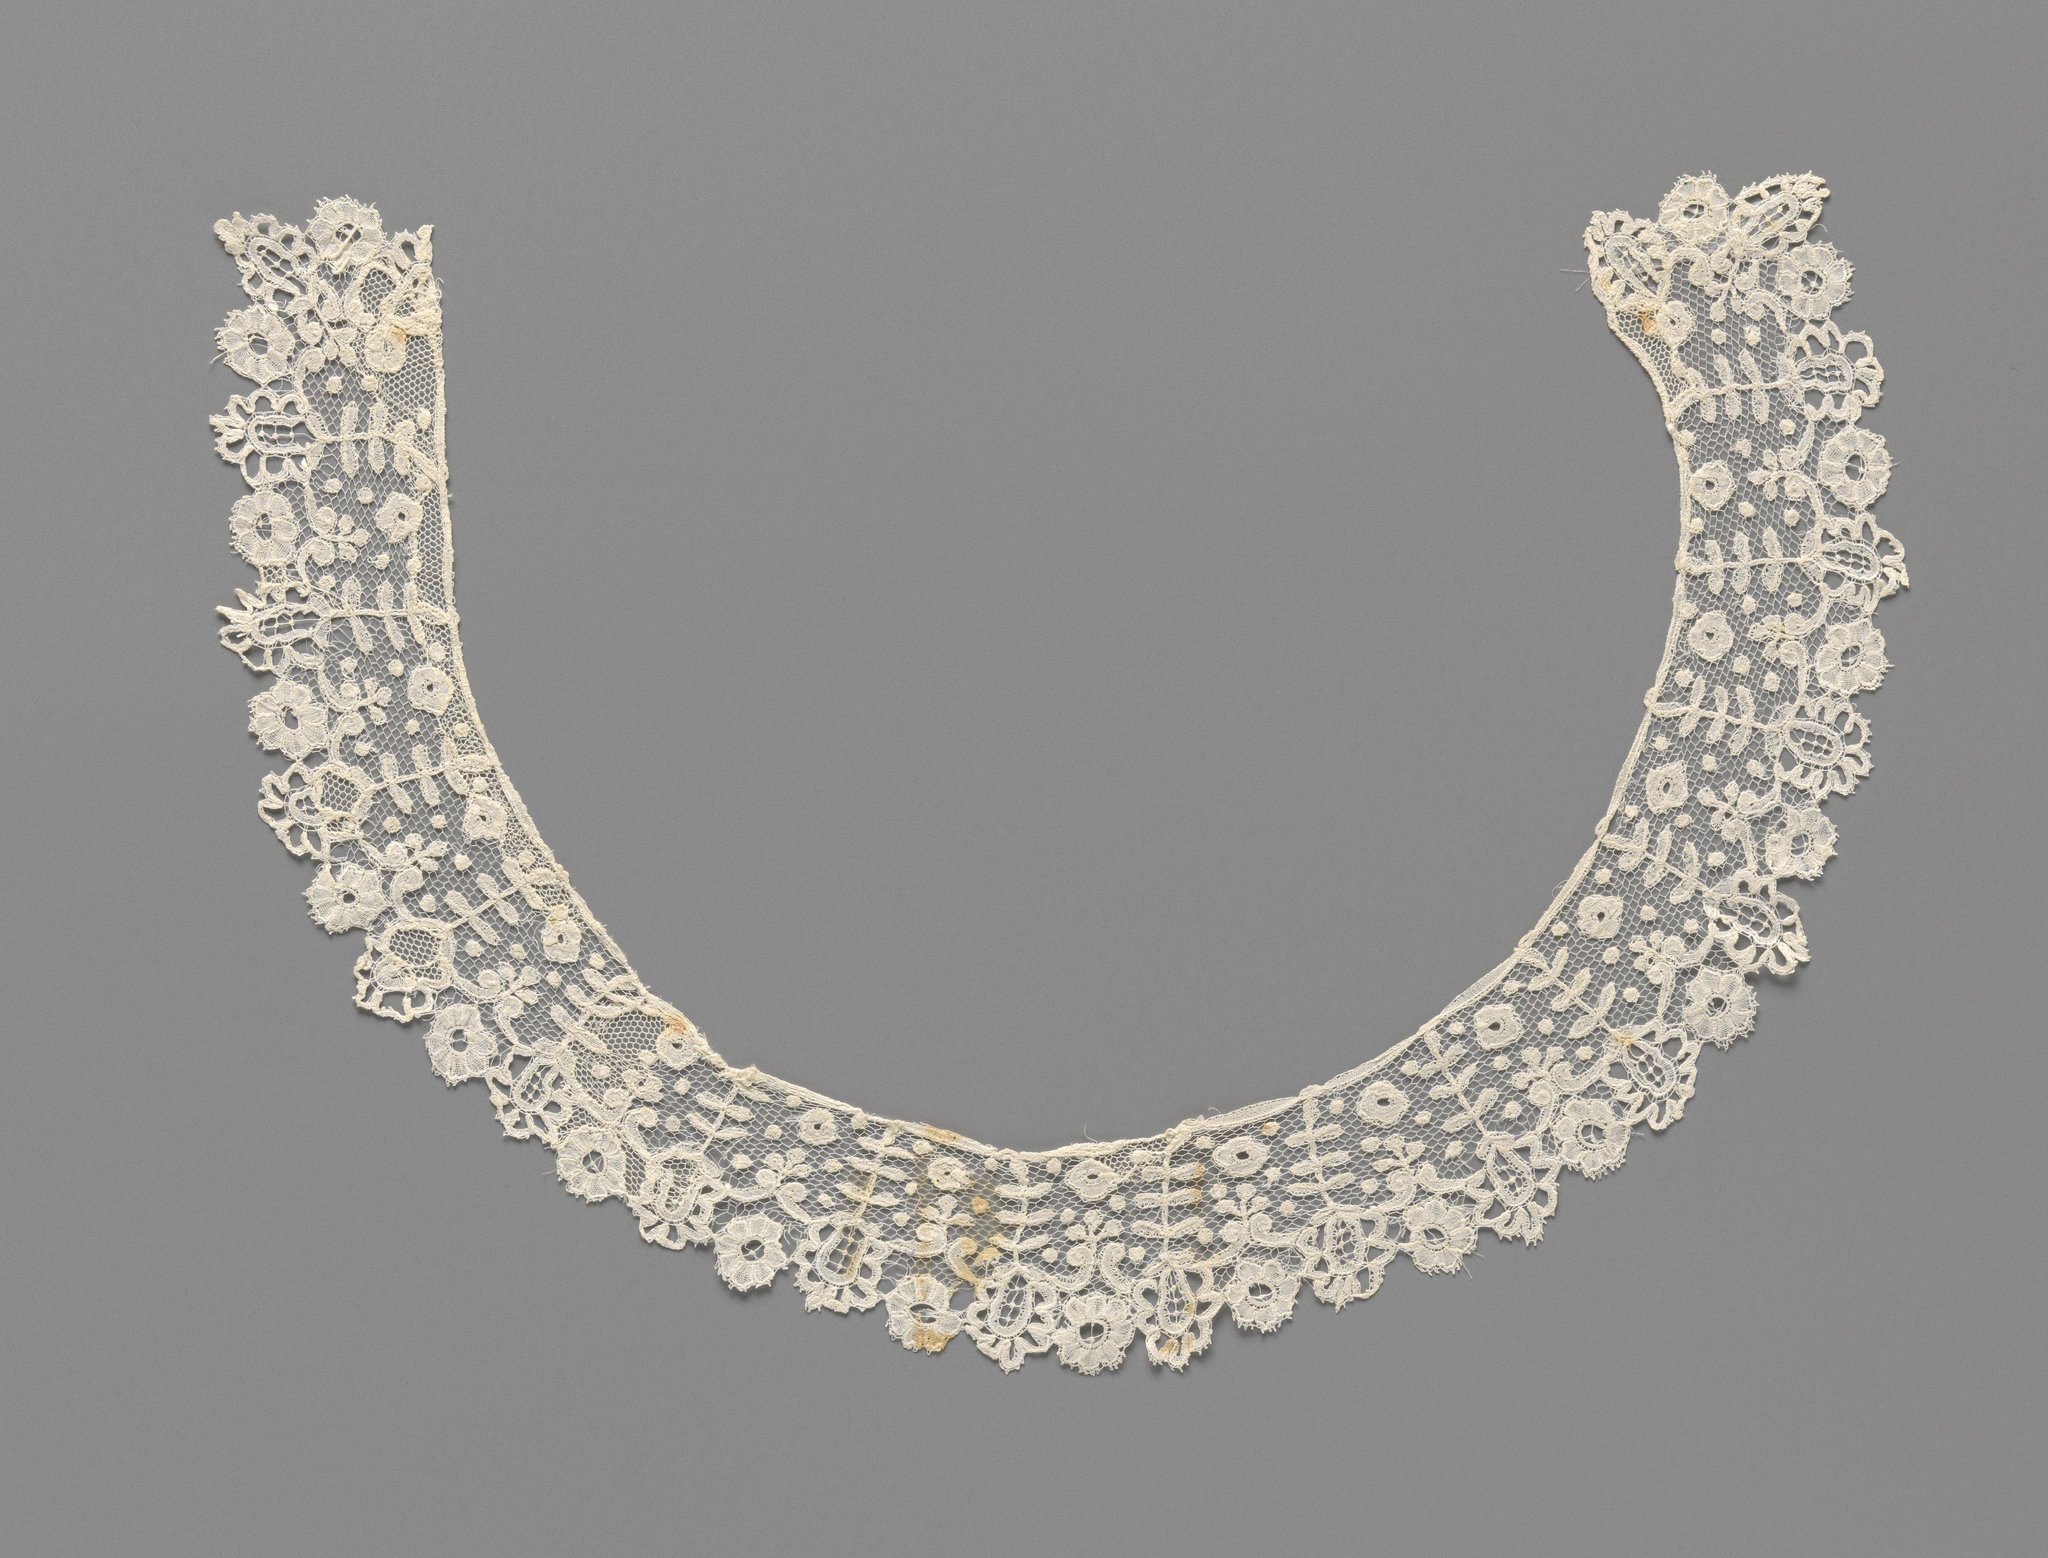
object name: collar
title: Kraag van applicatiekant met hangende bloemen met ovaal hart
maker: Anonymous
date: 1860-1869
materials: linen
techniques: lace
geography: brussels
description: Kraag van naturelkleurige Brusselse applicatiekant: kloskant geappliceerd op machinale tule. Model: tot een halve cirkel gevormde strook. Het patroon bestaat uit straalsgewijs geplaatste bloemstengels, met onderaan elke stengel een langwerpige bloem met een ovaal bloemhart. De schulpenrand wordt gevormd door deze bloemen en de hiertussen geplaatste stengelloze rozetbloemen. In het veldje boven de rozetbloemen staan, tussen enkele moesjes, symmetrisch geplaatste c-voluutjes, een takje met drie besjes en daarboven een rozetbloempje met vier bloemblaadjes. De motieven zijn geklost in linnenslag en voorzien van glimmende contourdraden. In de bloemharten van de bloemen die de schulpenrand vormen zijn enkele siersteken van naaldkant toegepast.